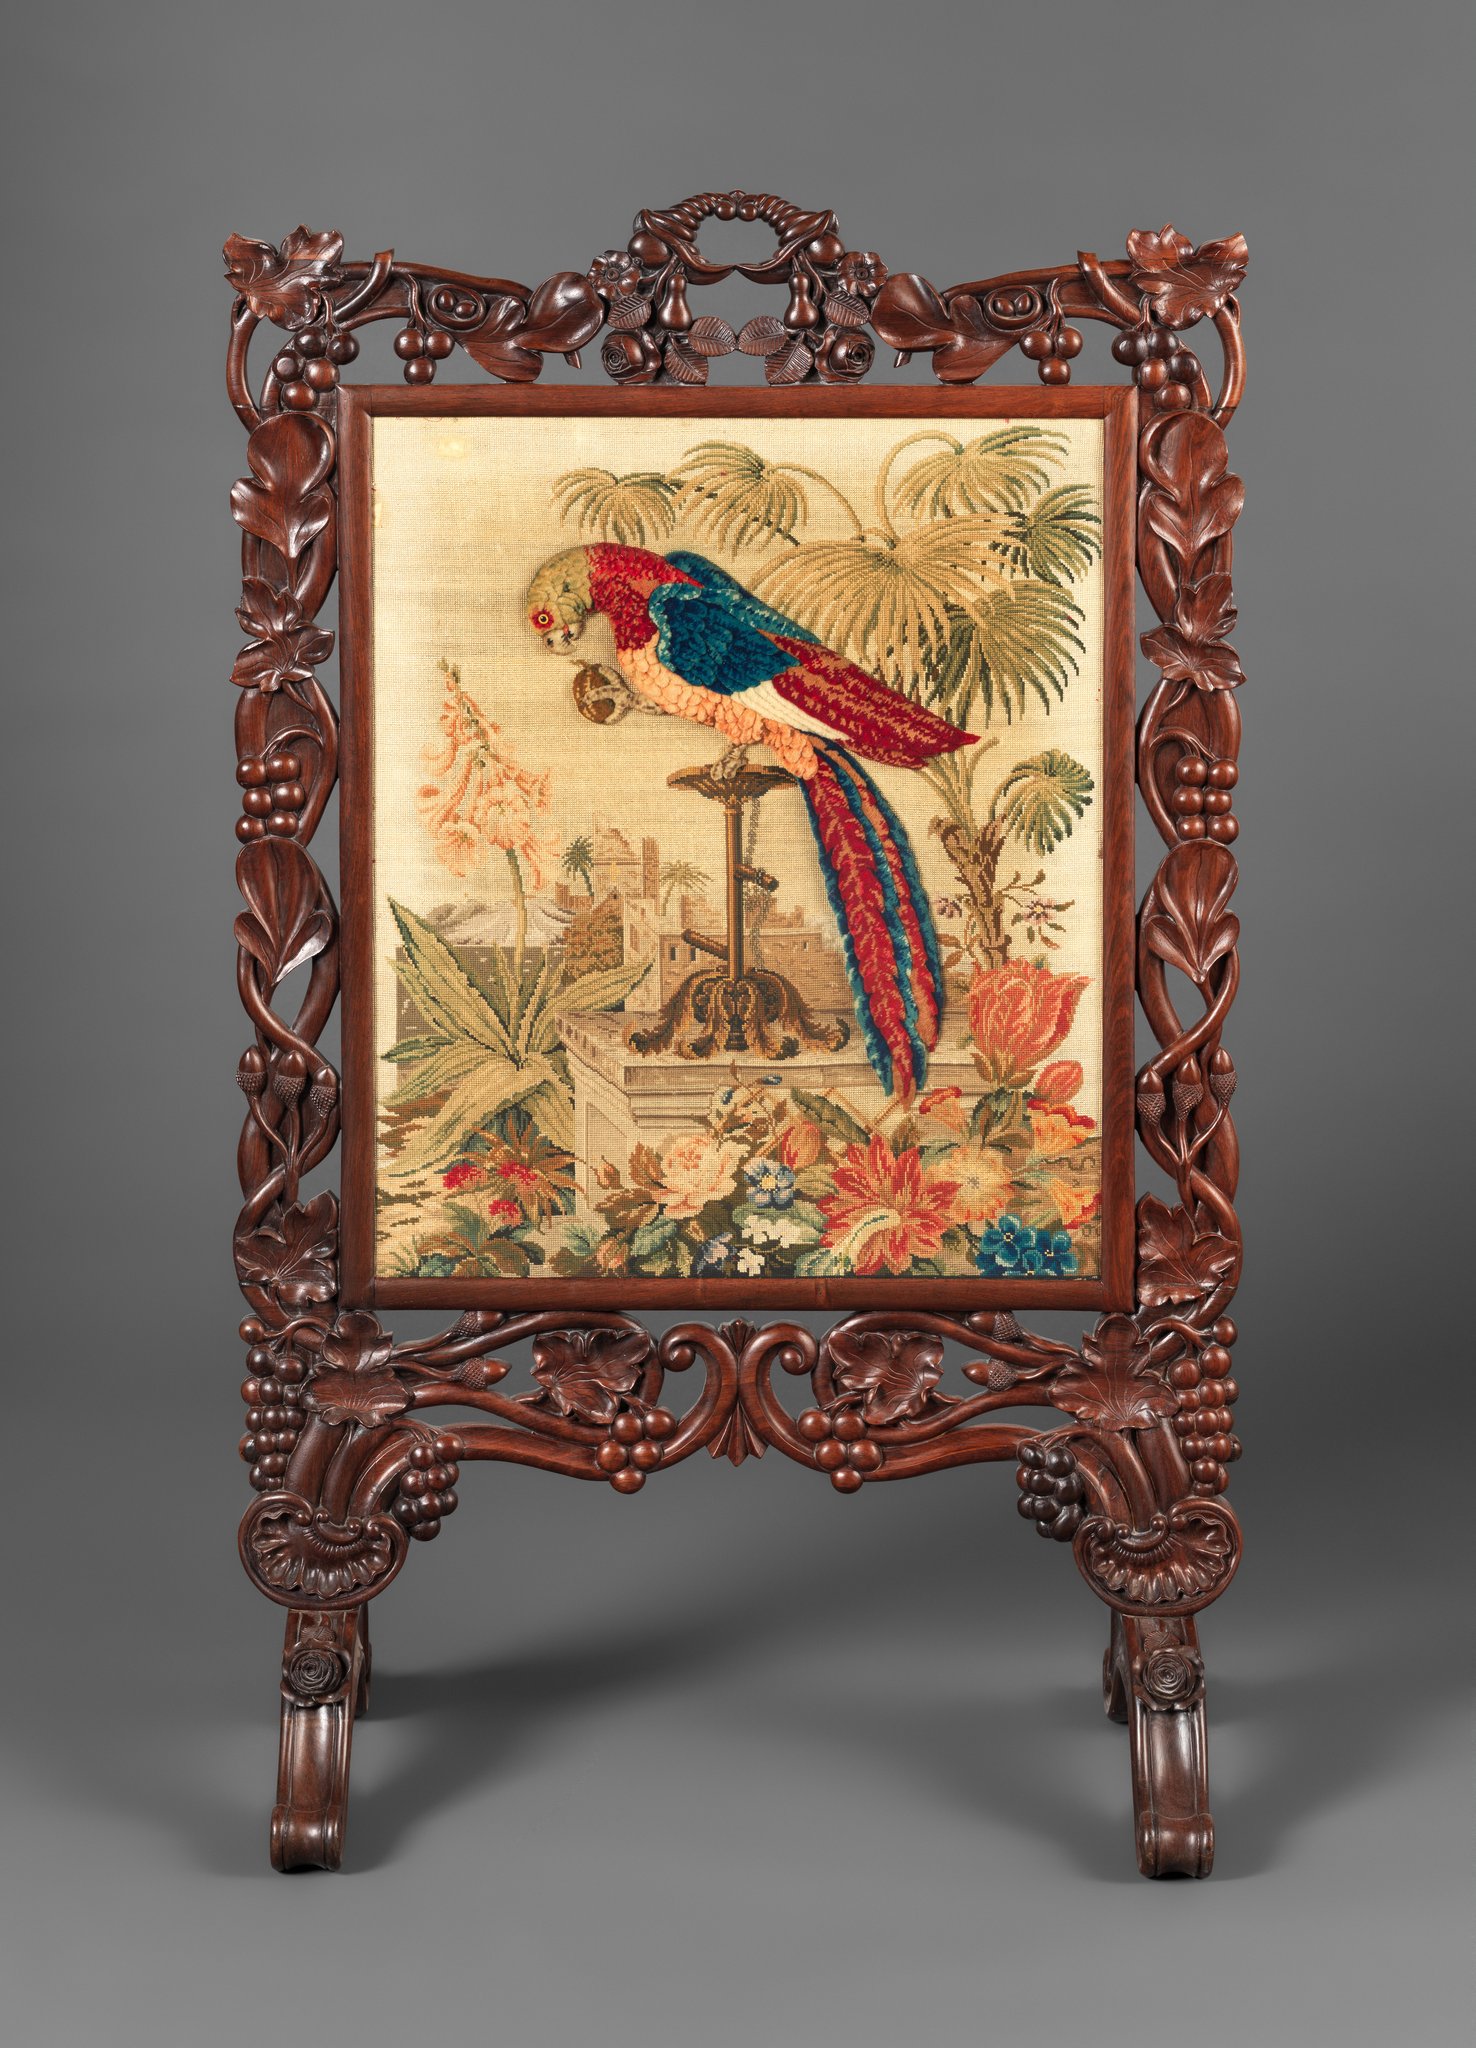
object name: firescreen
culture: american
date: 1850-1860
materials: wood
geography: united states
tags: parrots